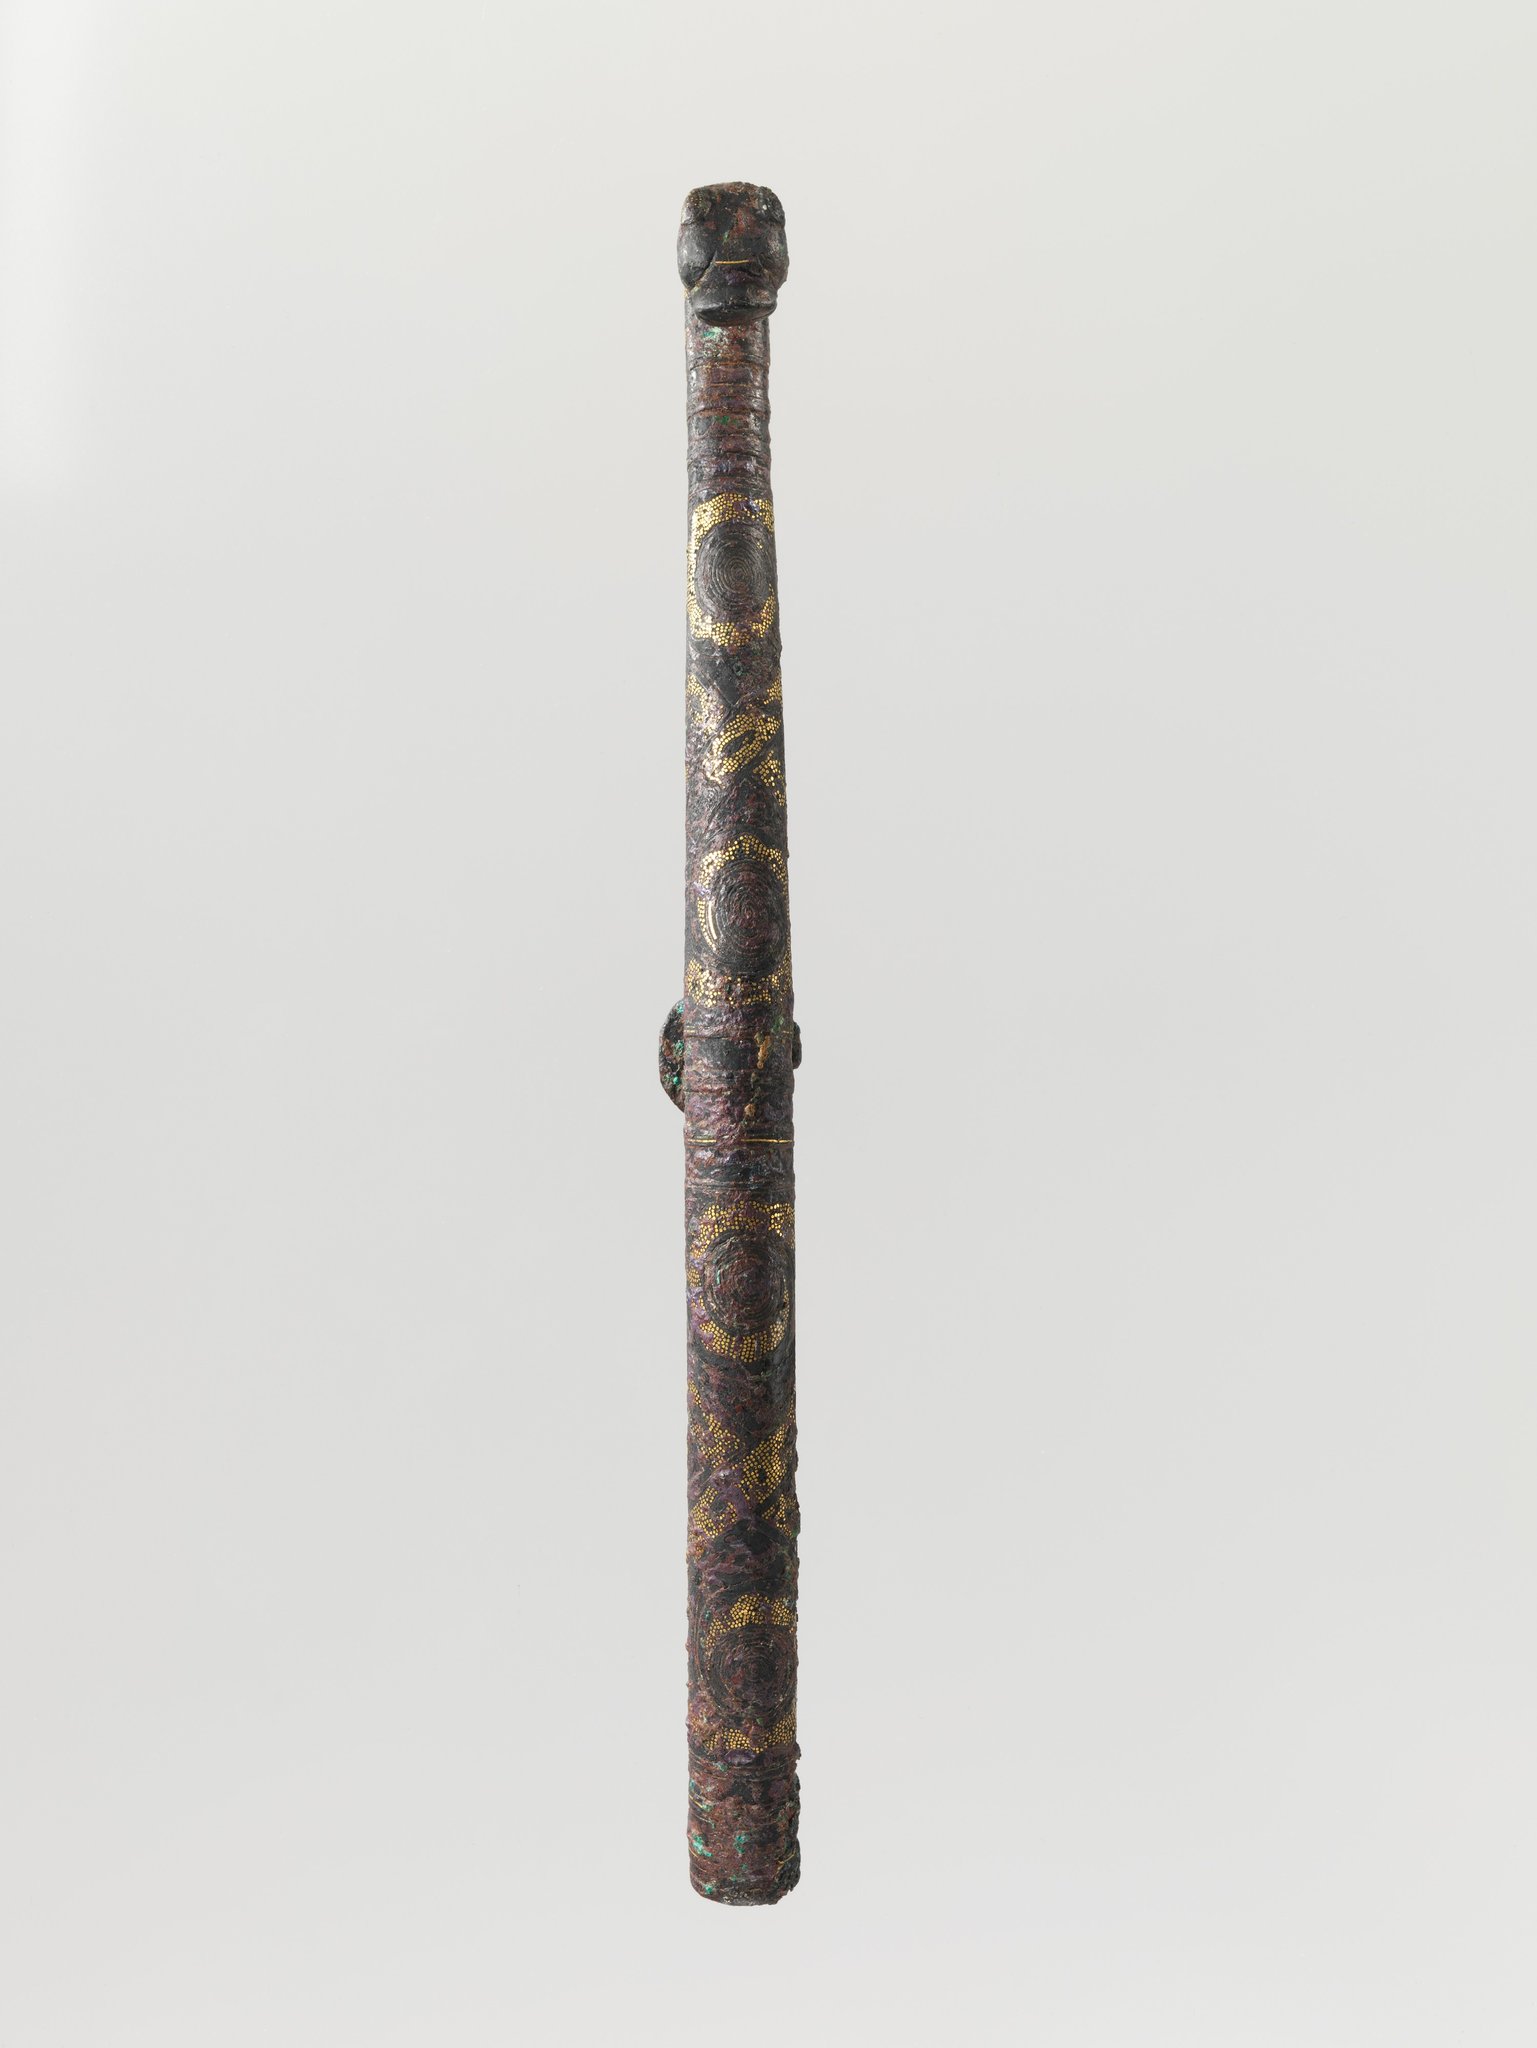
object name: belt hook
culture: chinese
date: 400-201 BCE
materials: bronze, gold, silver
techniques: inlay